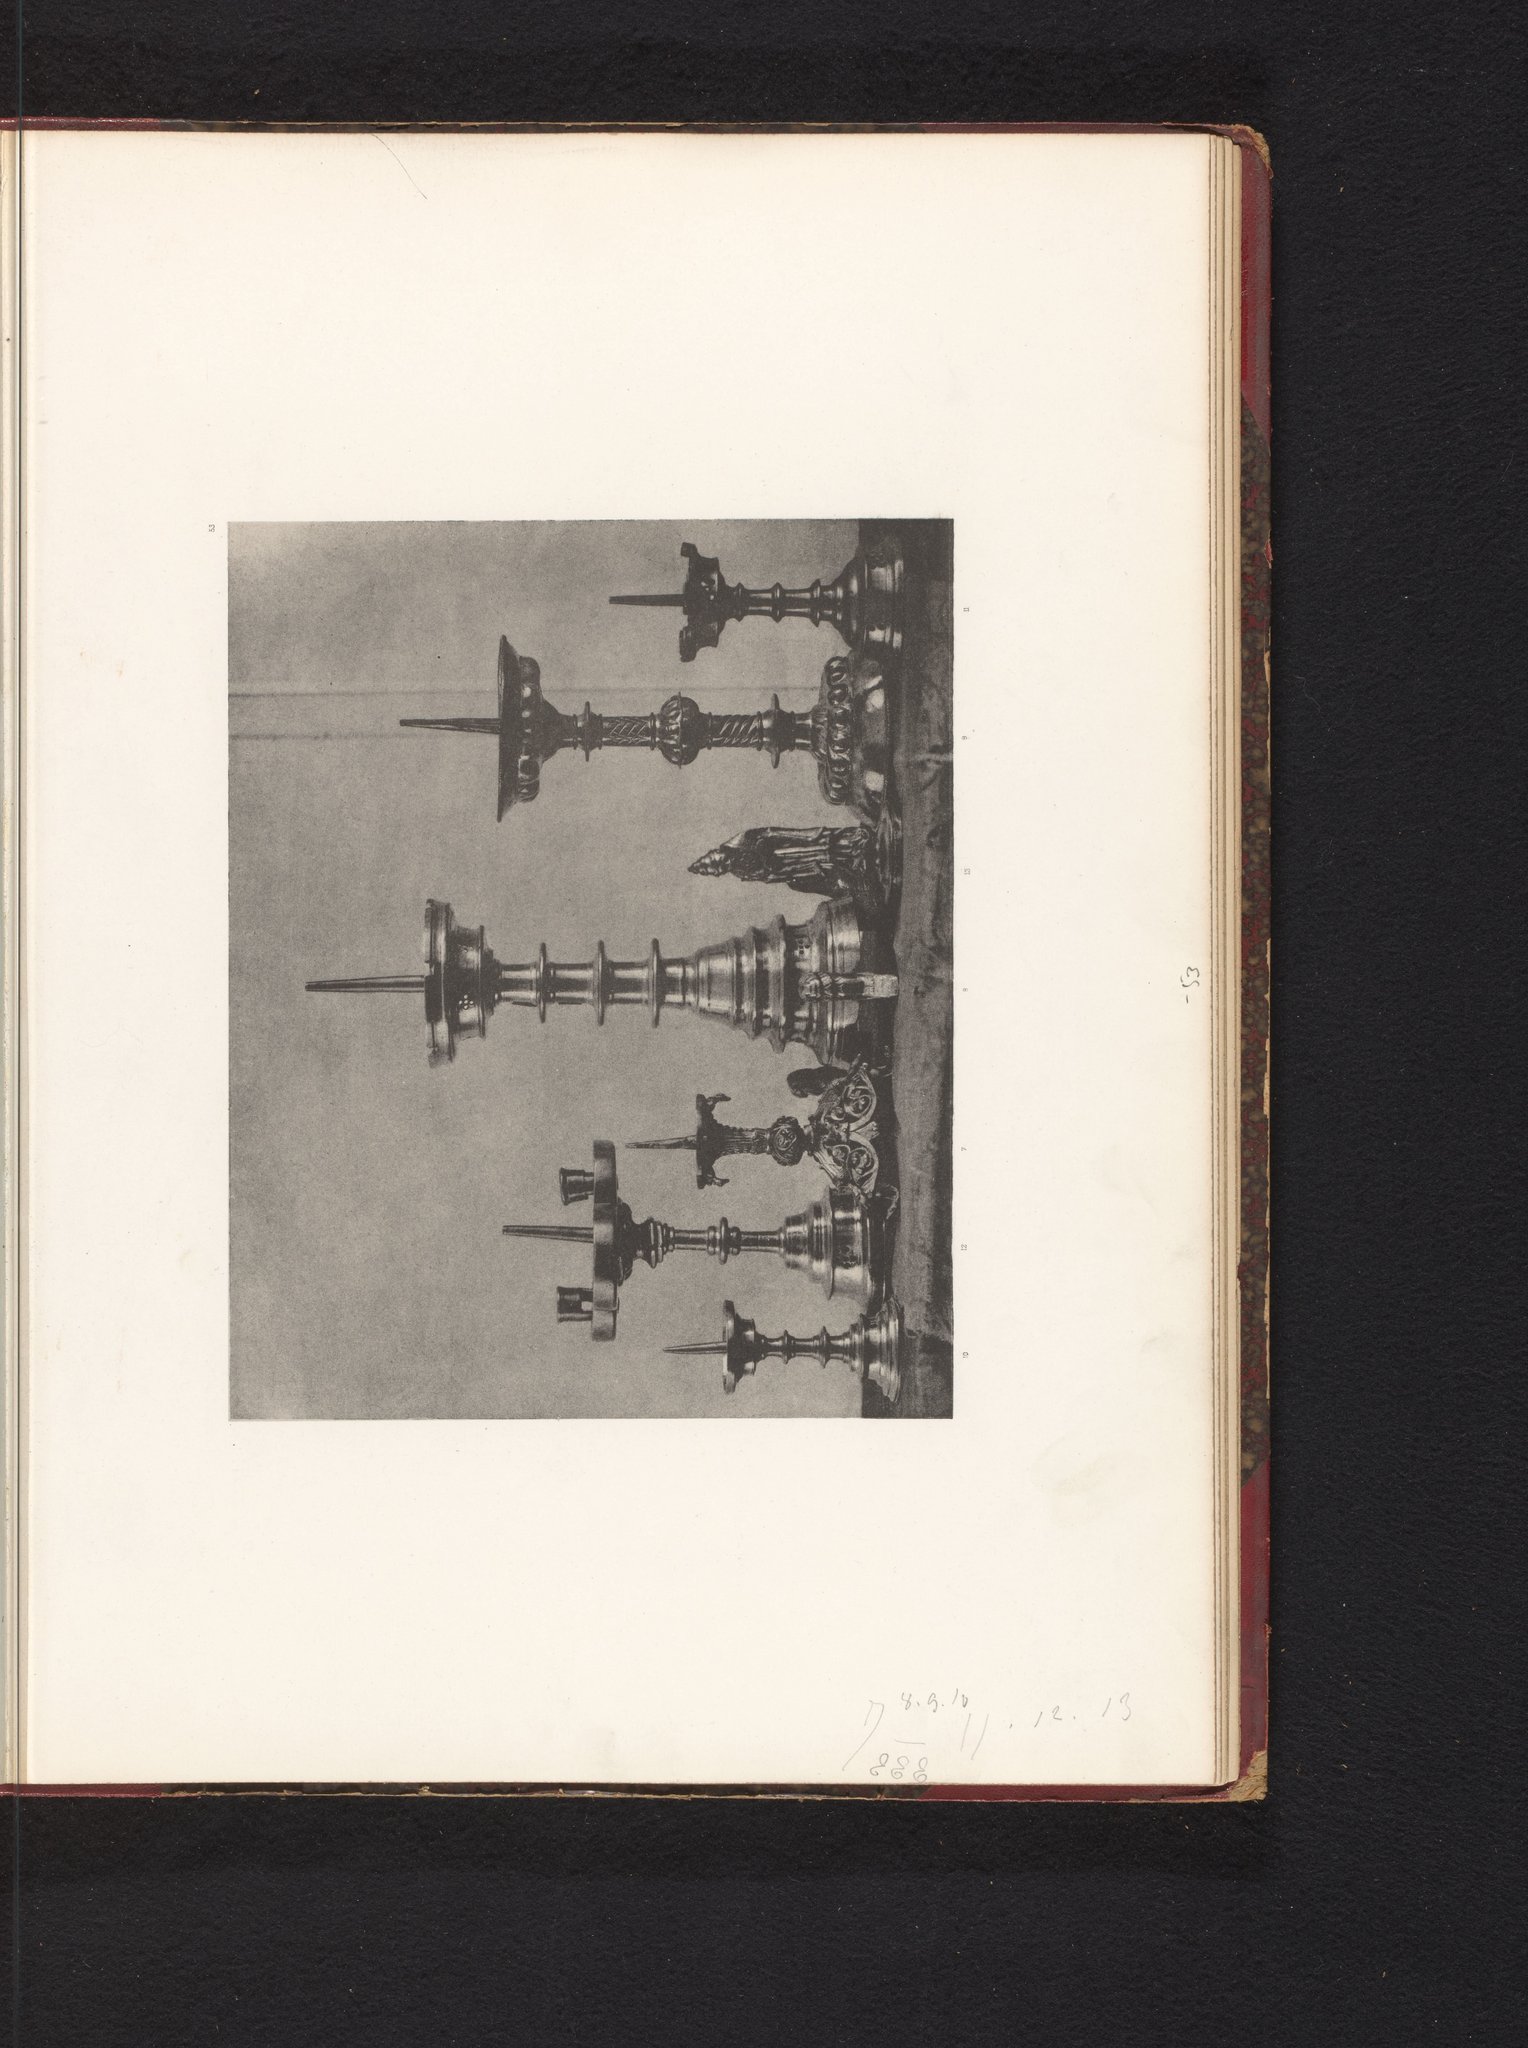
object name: page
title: Zeven metalen kandelaars, opgesteld op een tentoonstelling over religieuze objecten uit de middeleeuwen en renaissance in 1864 in Mechelen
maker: joseph maes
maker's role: fotograaf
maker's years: 1838-1908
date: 1864-1866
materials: paper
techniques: photolithography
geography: antwerp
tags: altar accoutrement, candlestick, mechelen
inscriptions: number: ‘10 - 12 - 7 - 8 - 13 - 9 - 11’, number: ‘-53’, number: ‘7. 8. 9. 10./ 11. 12. 13./ [...]’